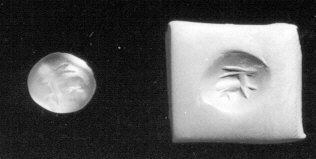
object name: stamp seal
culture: sasanian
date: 201-700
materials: gemstone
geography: iran